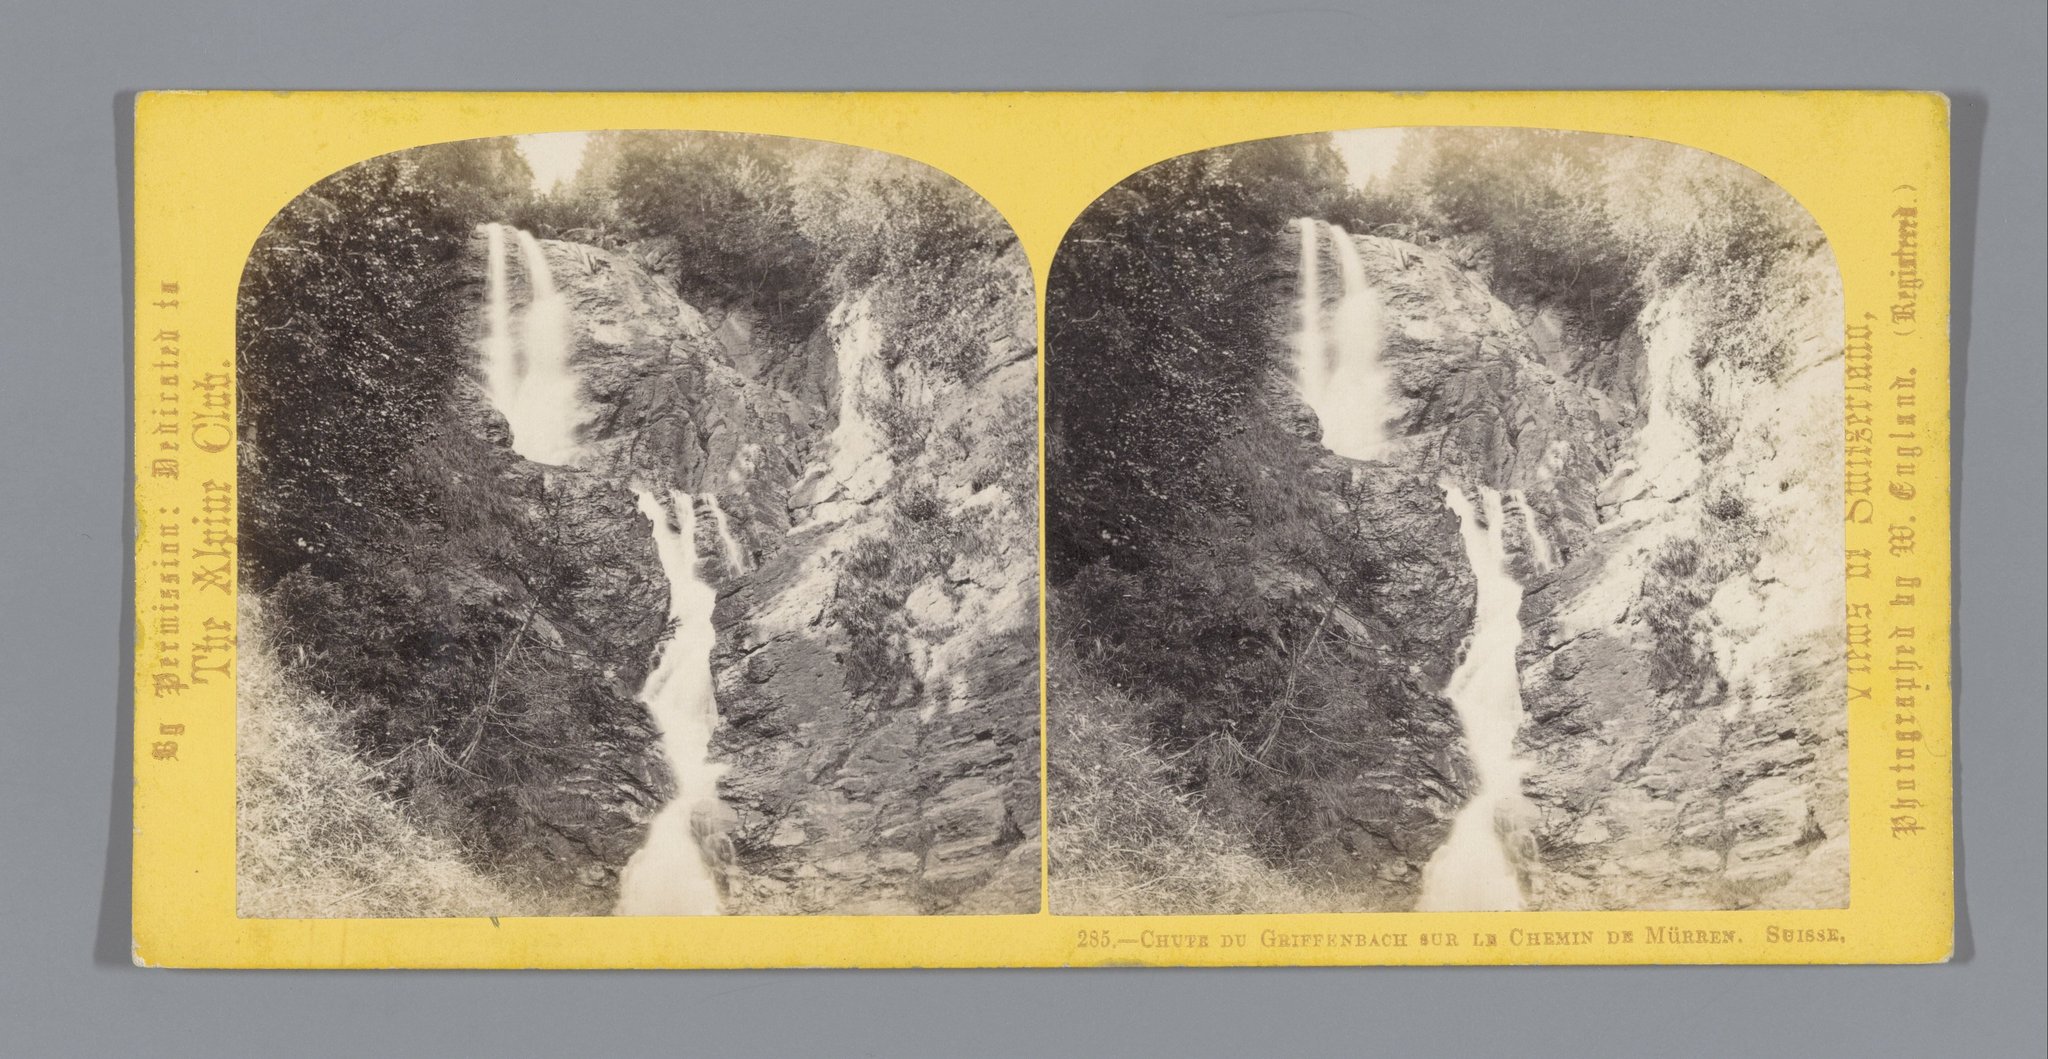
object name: stereograph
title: Gezicht op de Griffenbachwatervallen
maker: william england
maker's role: fotograaf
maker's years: 1816-1896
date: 1850-1880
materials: cardboard, photographic support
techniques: albumen print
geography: bern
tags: waterfall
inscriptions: inscription: ‘Views of Switzerland, photographed by W. England. (Registered) Under the Special Patronage of the Alpine Club.’, number: ‘285.’